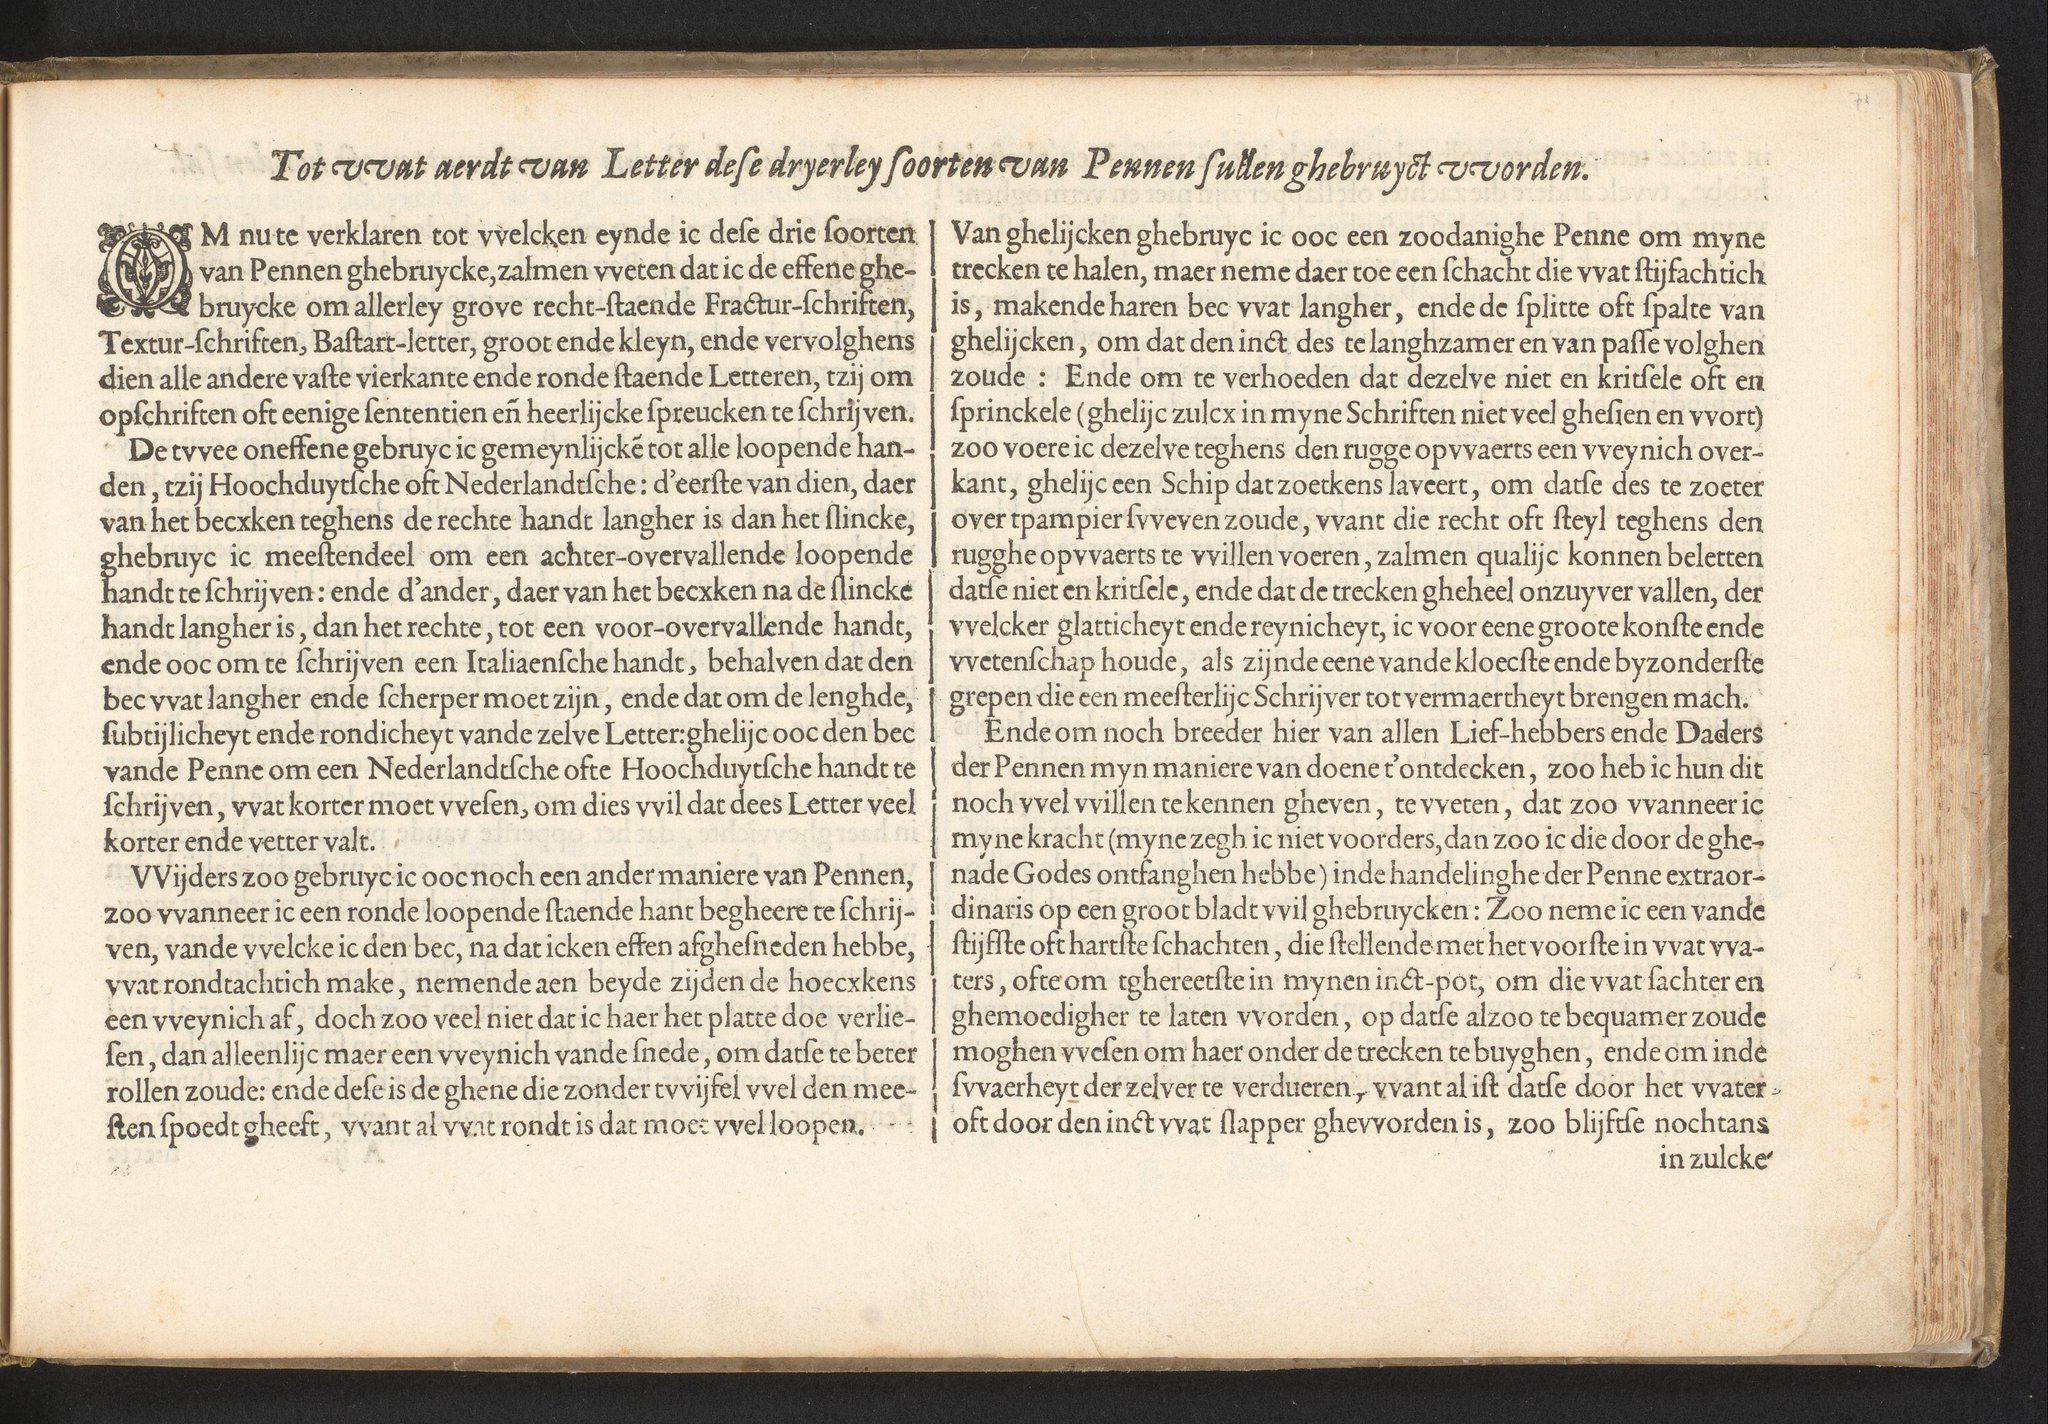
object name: text sheet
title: Gebruik van drie soorten rietpennen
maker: jan van de velde (i)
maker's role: painter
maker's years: 1568-1623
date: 1605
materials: paper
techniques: letterpress printing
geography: rotterdam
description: Folio A2r. Tekstblad met een beschrijving van het gebruik van drie soorten rietpennen. De tekst begint met een kleine gedecoreerde initiaal O. Het tekstblad maakt deel uit van een album.